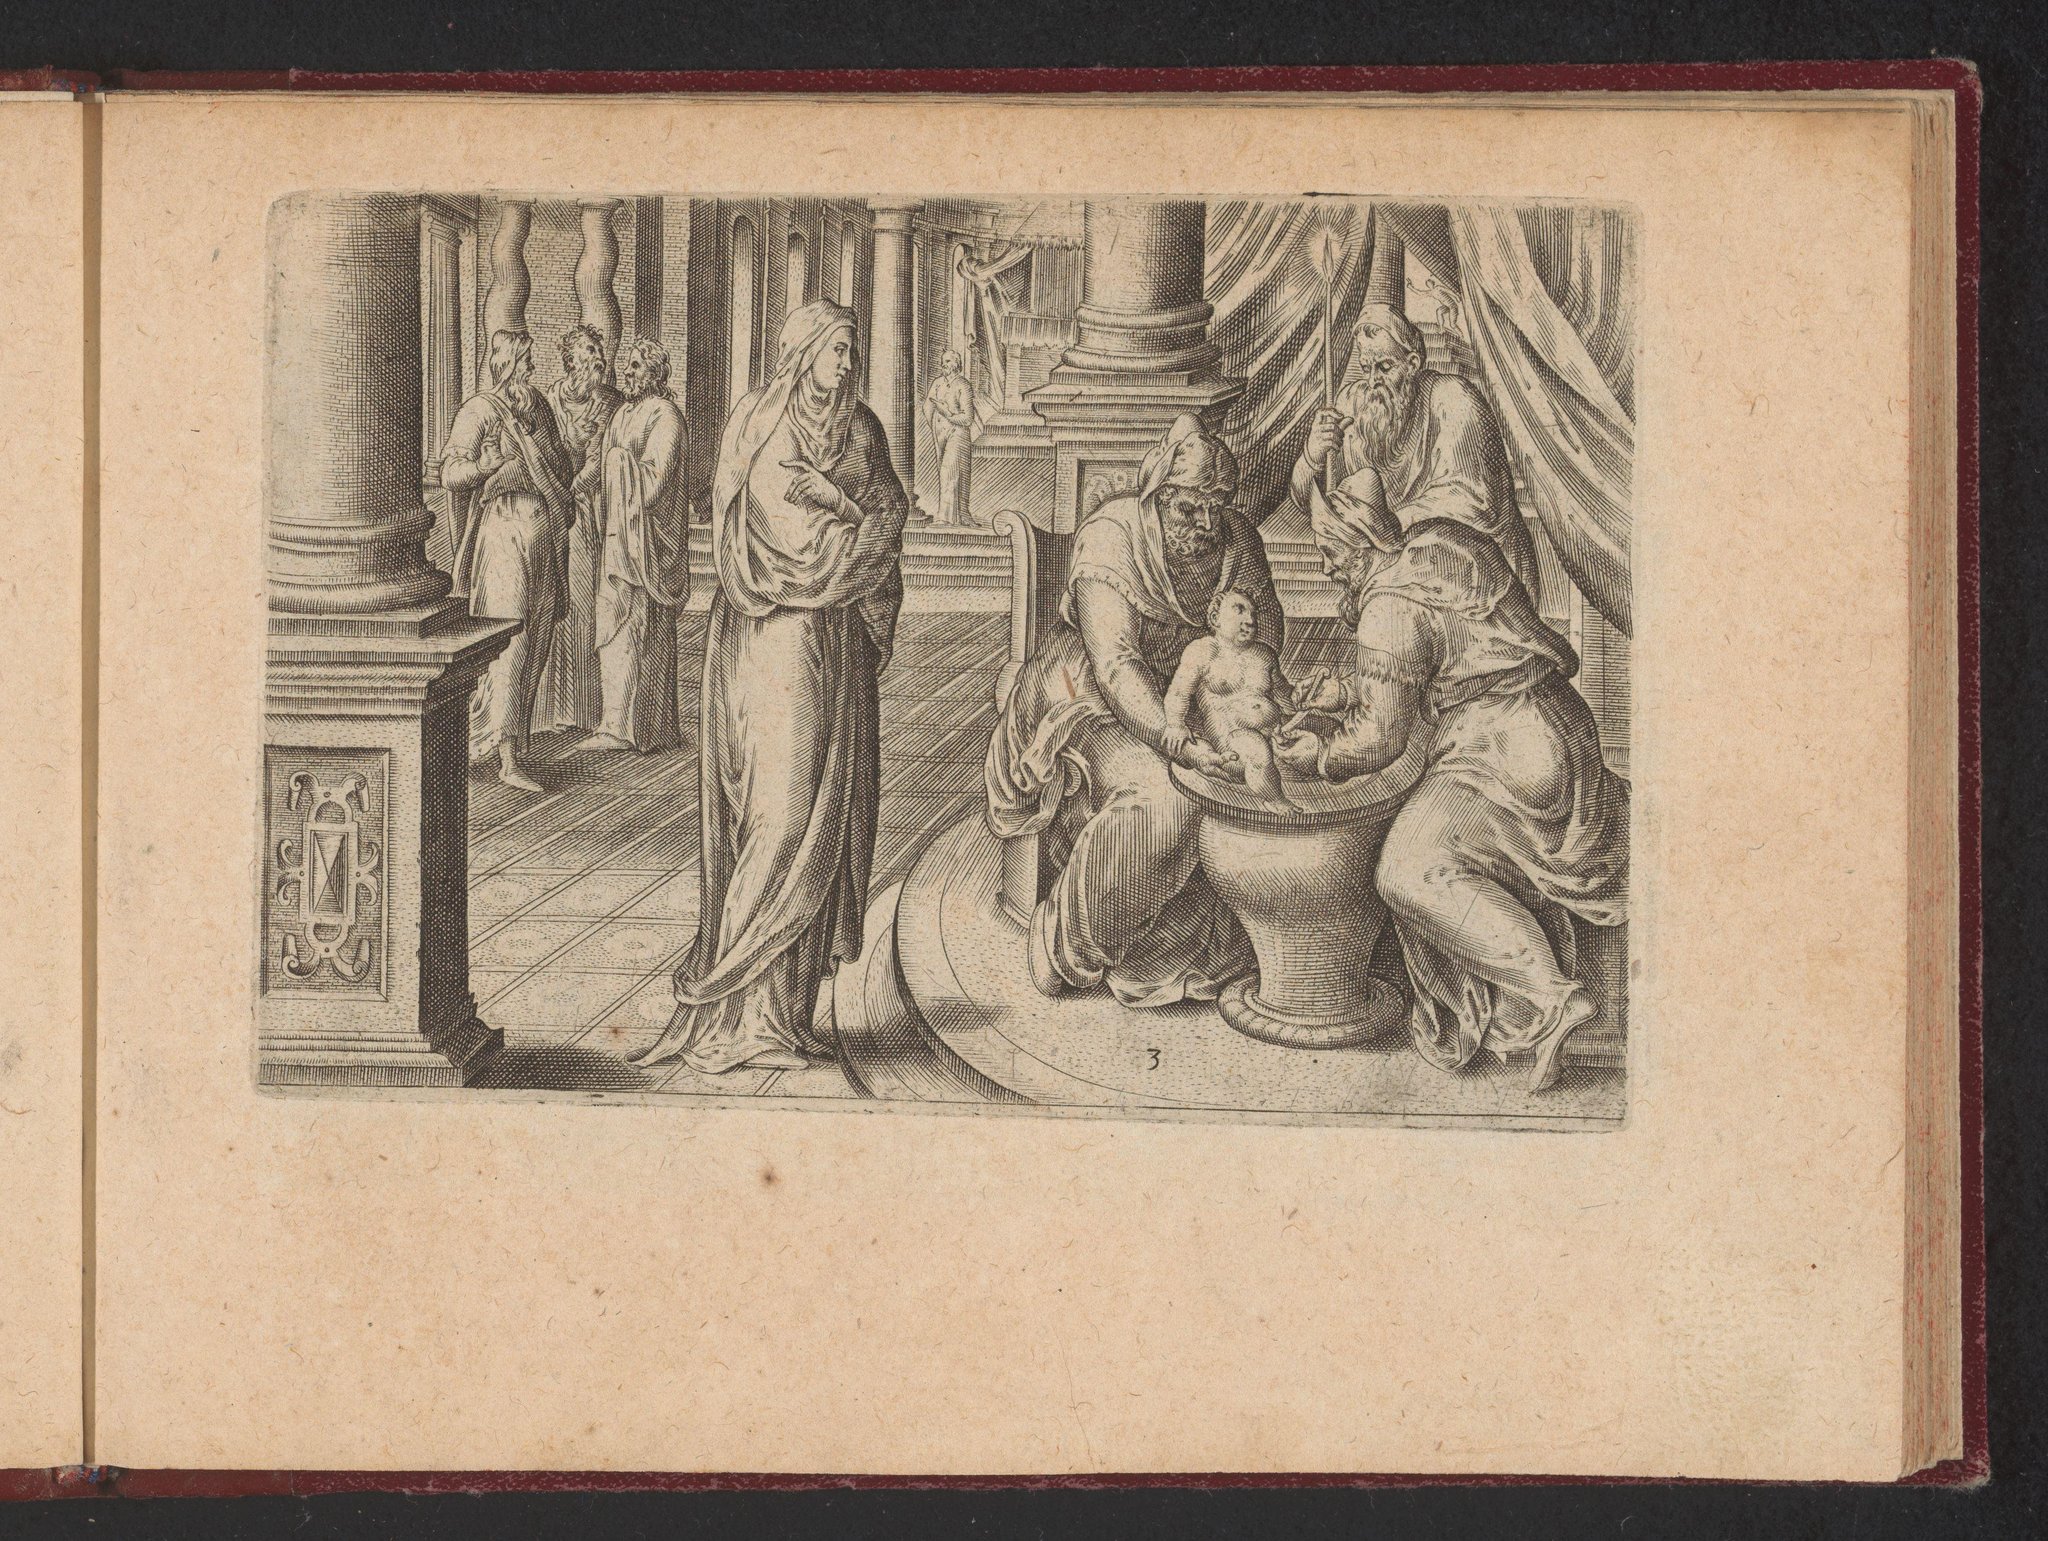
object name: print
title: Besnijdenis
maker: philips galle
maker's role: print maker, publisher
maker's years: 1537-1612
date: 1573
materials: paper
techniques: engraving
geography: antwerp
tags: circumcision of the christ-child by the priest in the temple (luke 2:21)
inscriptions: watermark: ‘gotische letter P’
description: Onderdeel van een album met een titelprent en een serie van 50 prenten betreffende het leven en de passie van Christus.